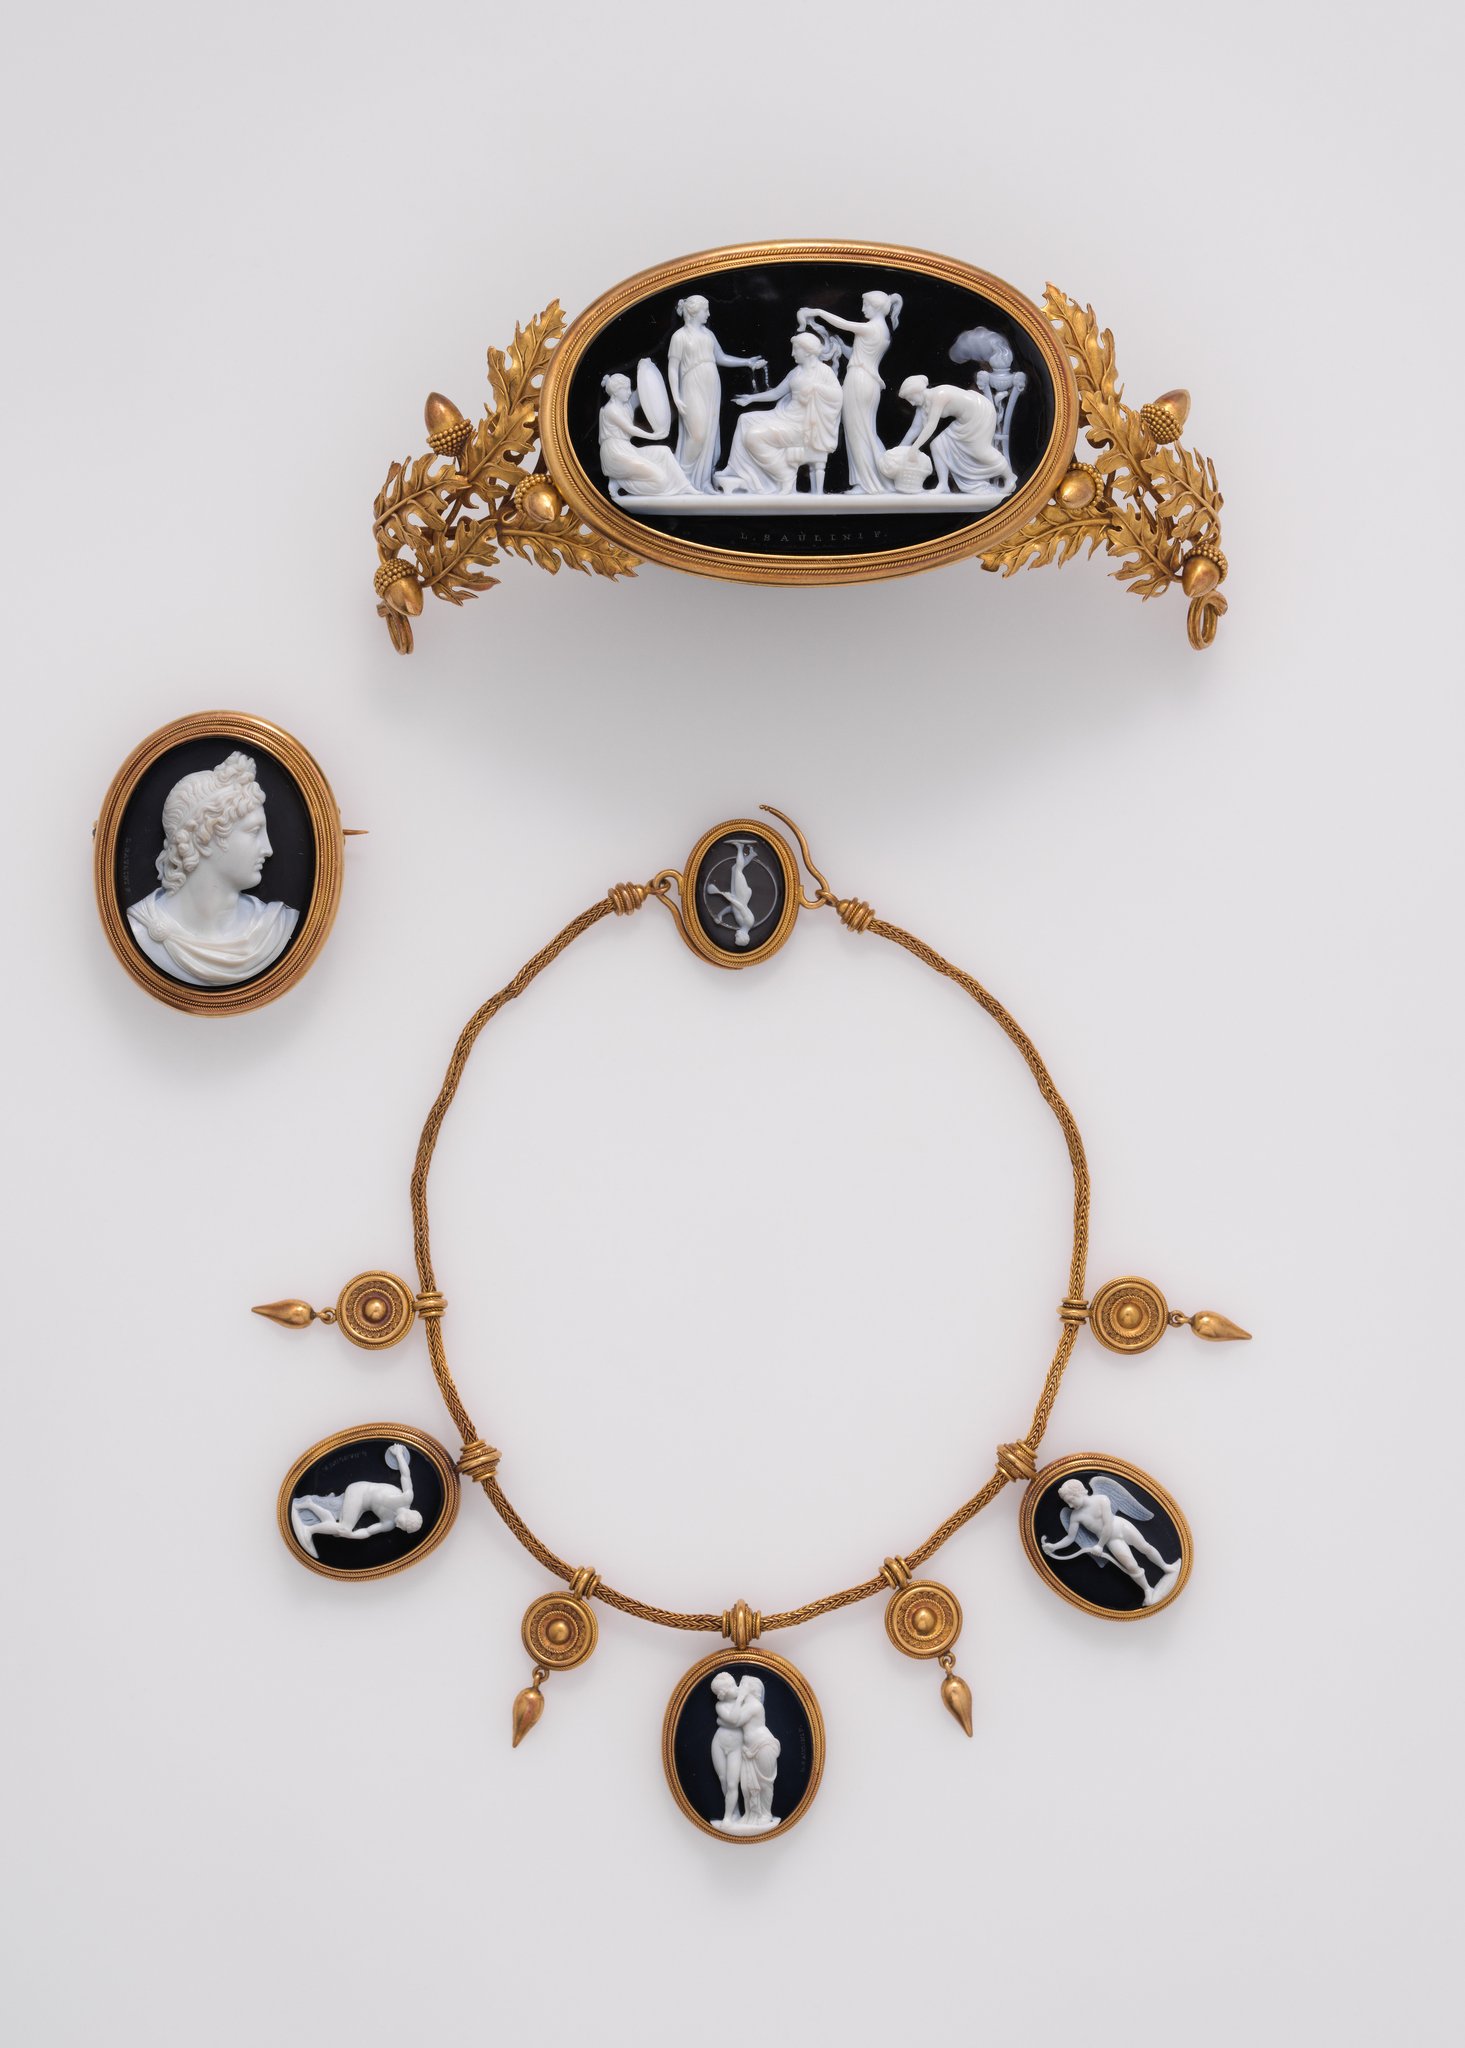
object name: parure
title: Parure: tiara, necklace, and brooch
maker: luigi saulini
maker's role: artist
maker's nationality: italian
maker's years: 1819-1883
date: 1834-1866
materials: gold, onyx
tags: cupid,apollo,psyche